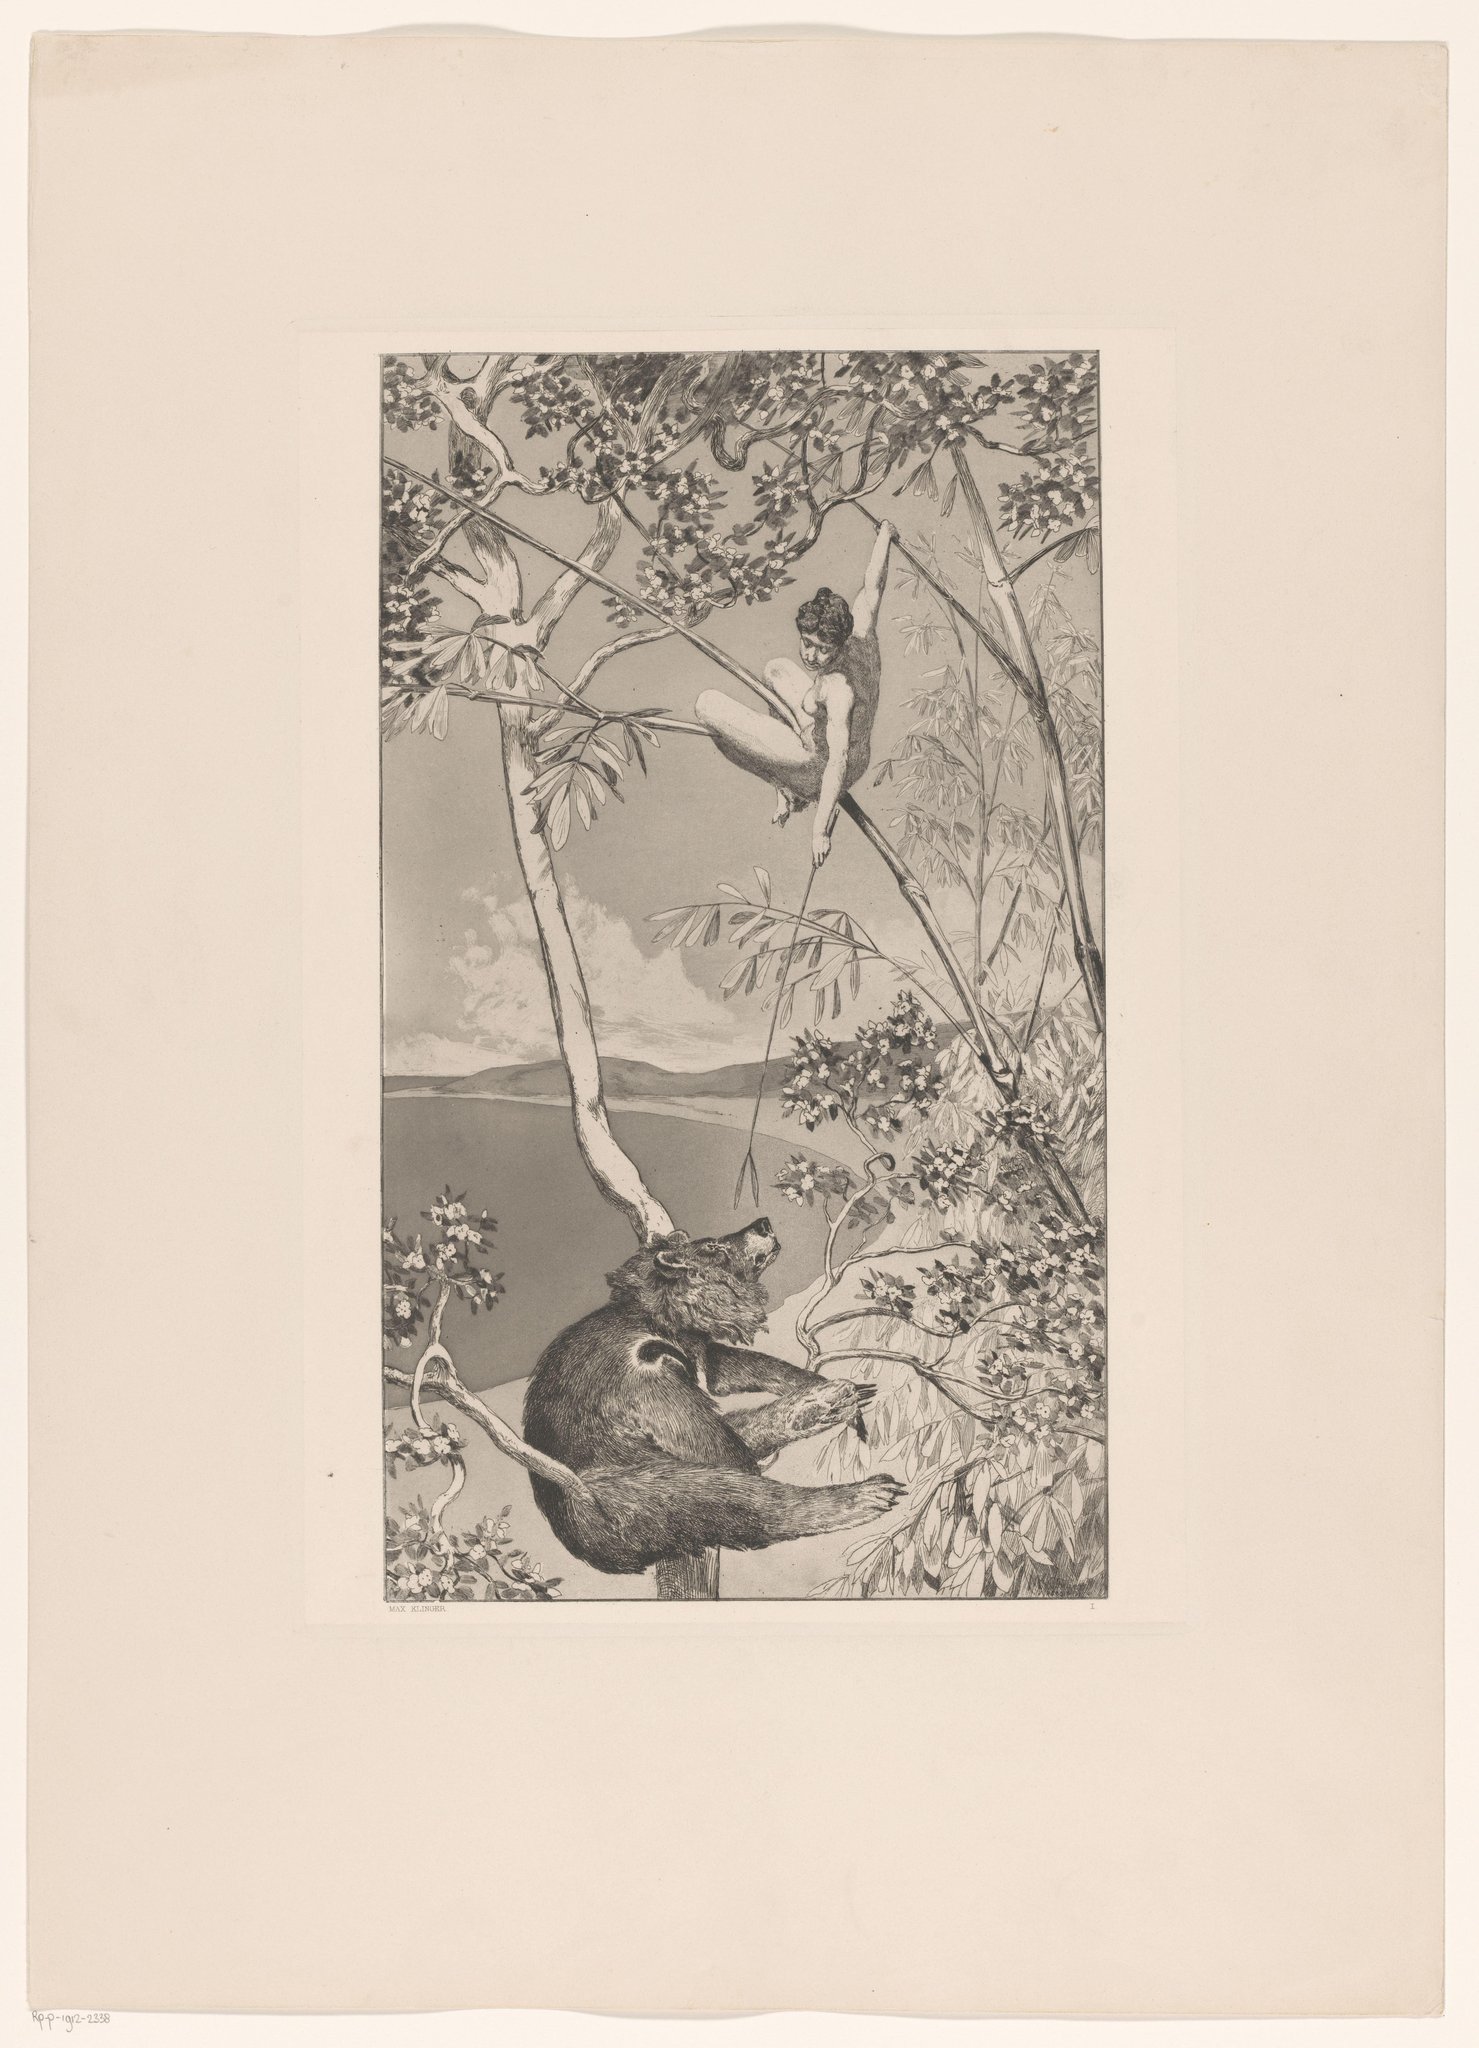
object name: print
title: Intermezzi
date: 1881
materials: paper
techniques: aquatint, etching, roulette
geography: nuremberg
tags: beasts of prey, predatory animals: bear, the (nude) human figure; 'corpo humano' (ripa) - aa - female human figure, coast, climbing up a tree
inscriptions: collector's mark: Lugt 2228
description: Prent één uit een serie van twaalf prenten.